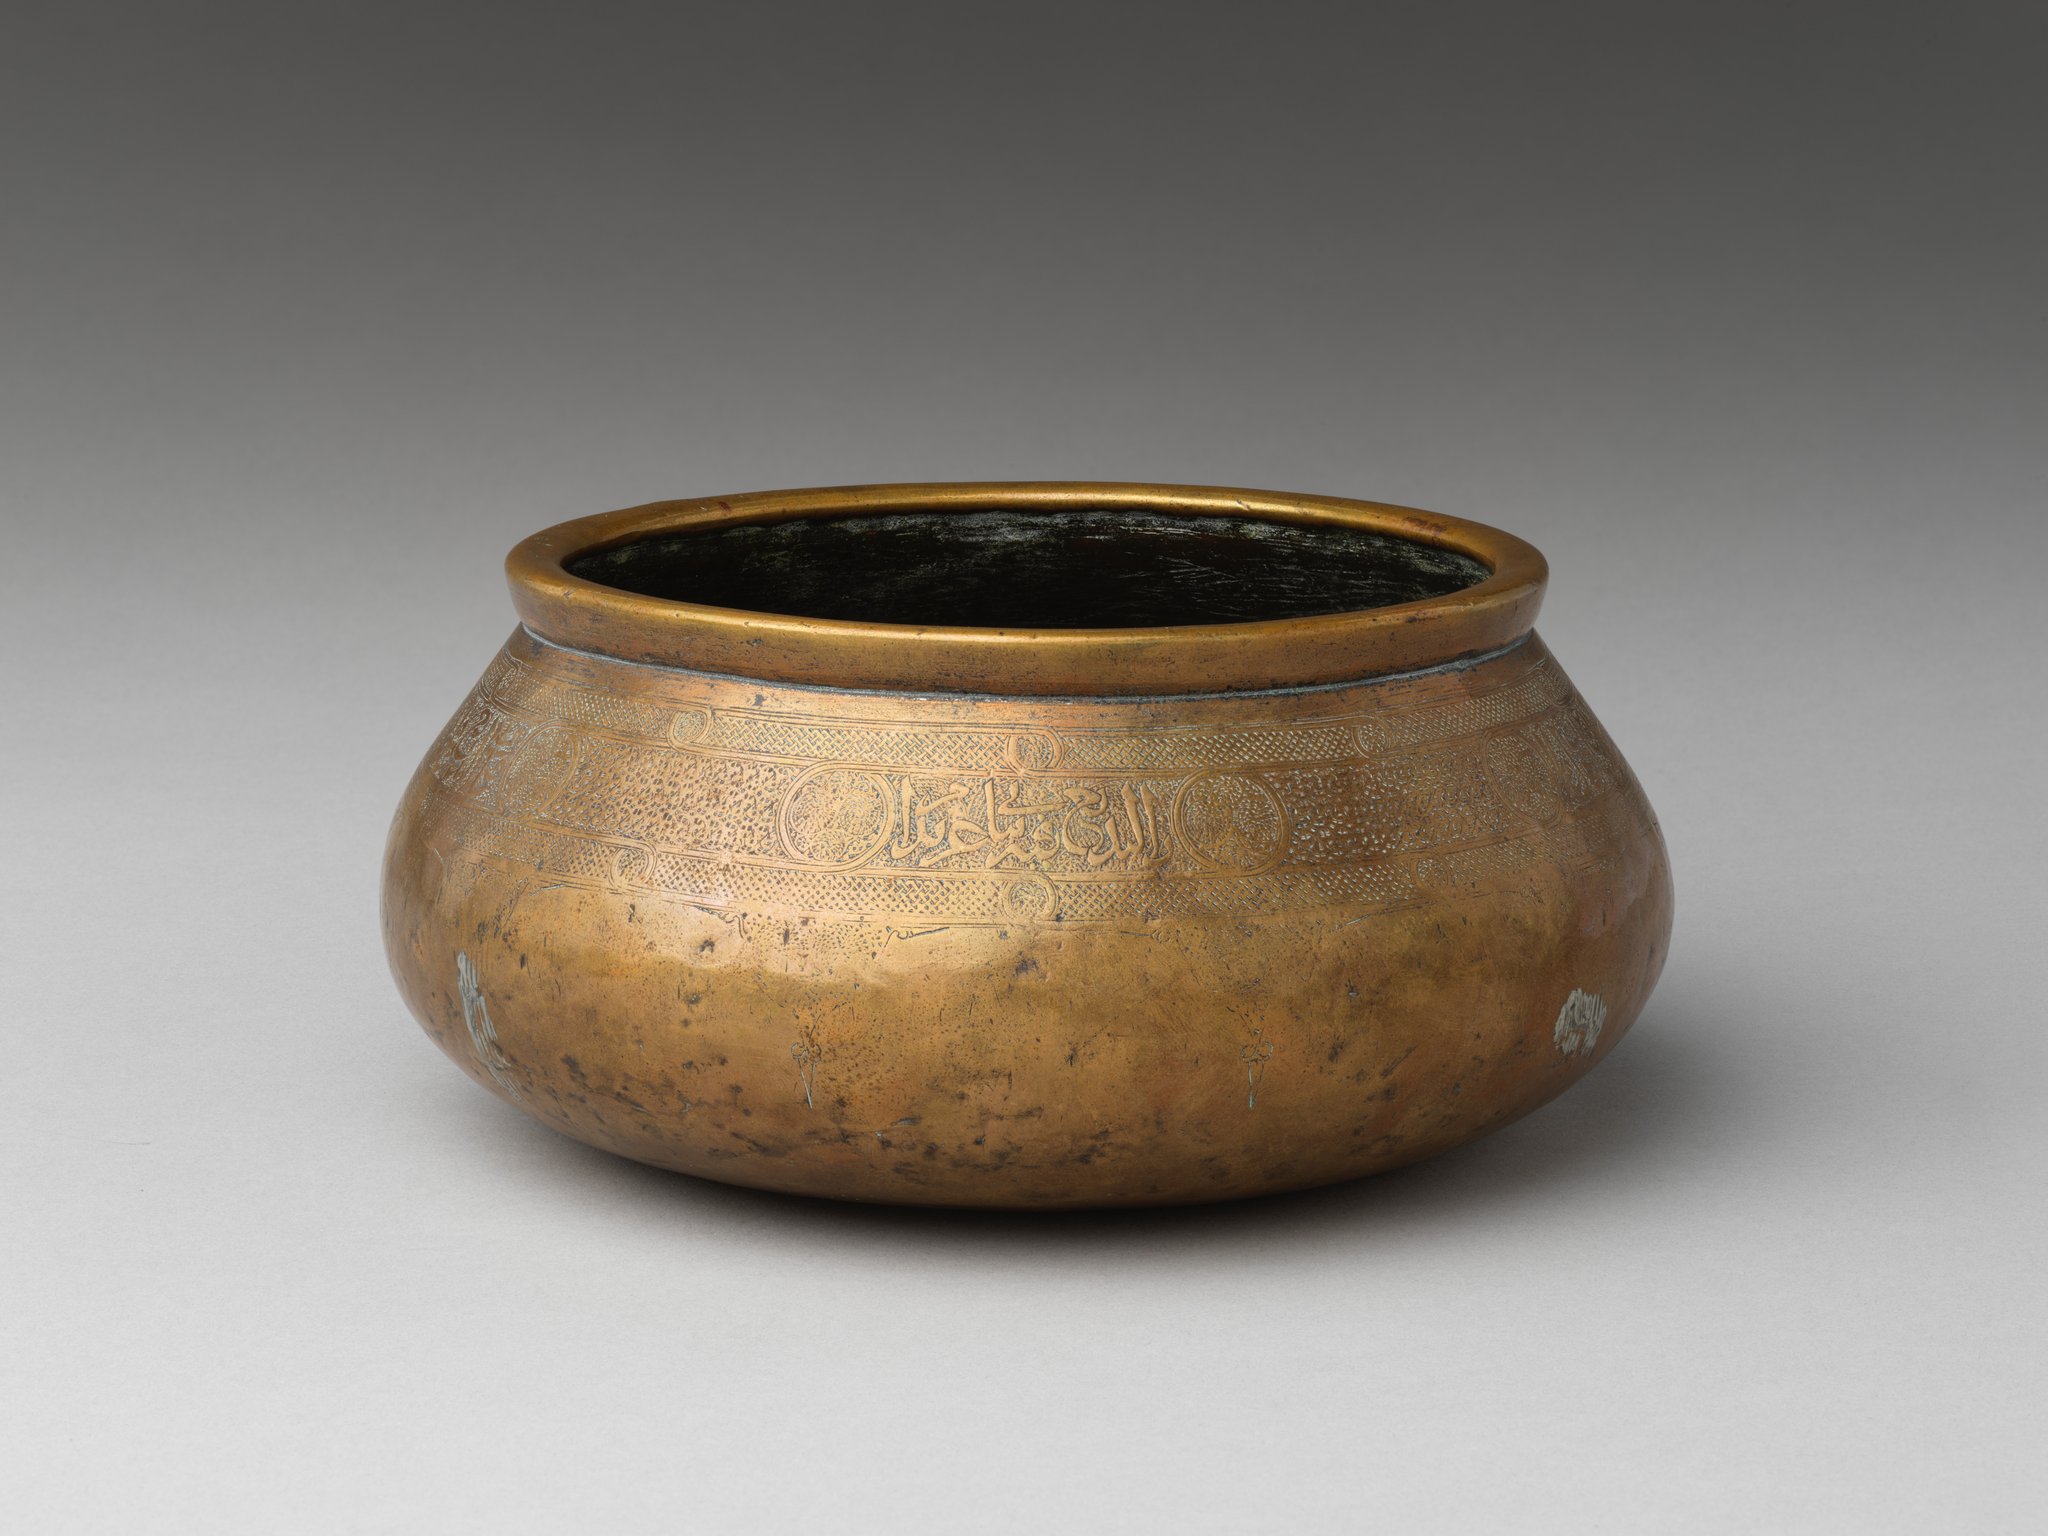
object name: bowl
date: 1301-1400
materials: brass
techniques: engraving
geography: iran